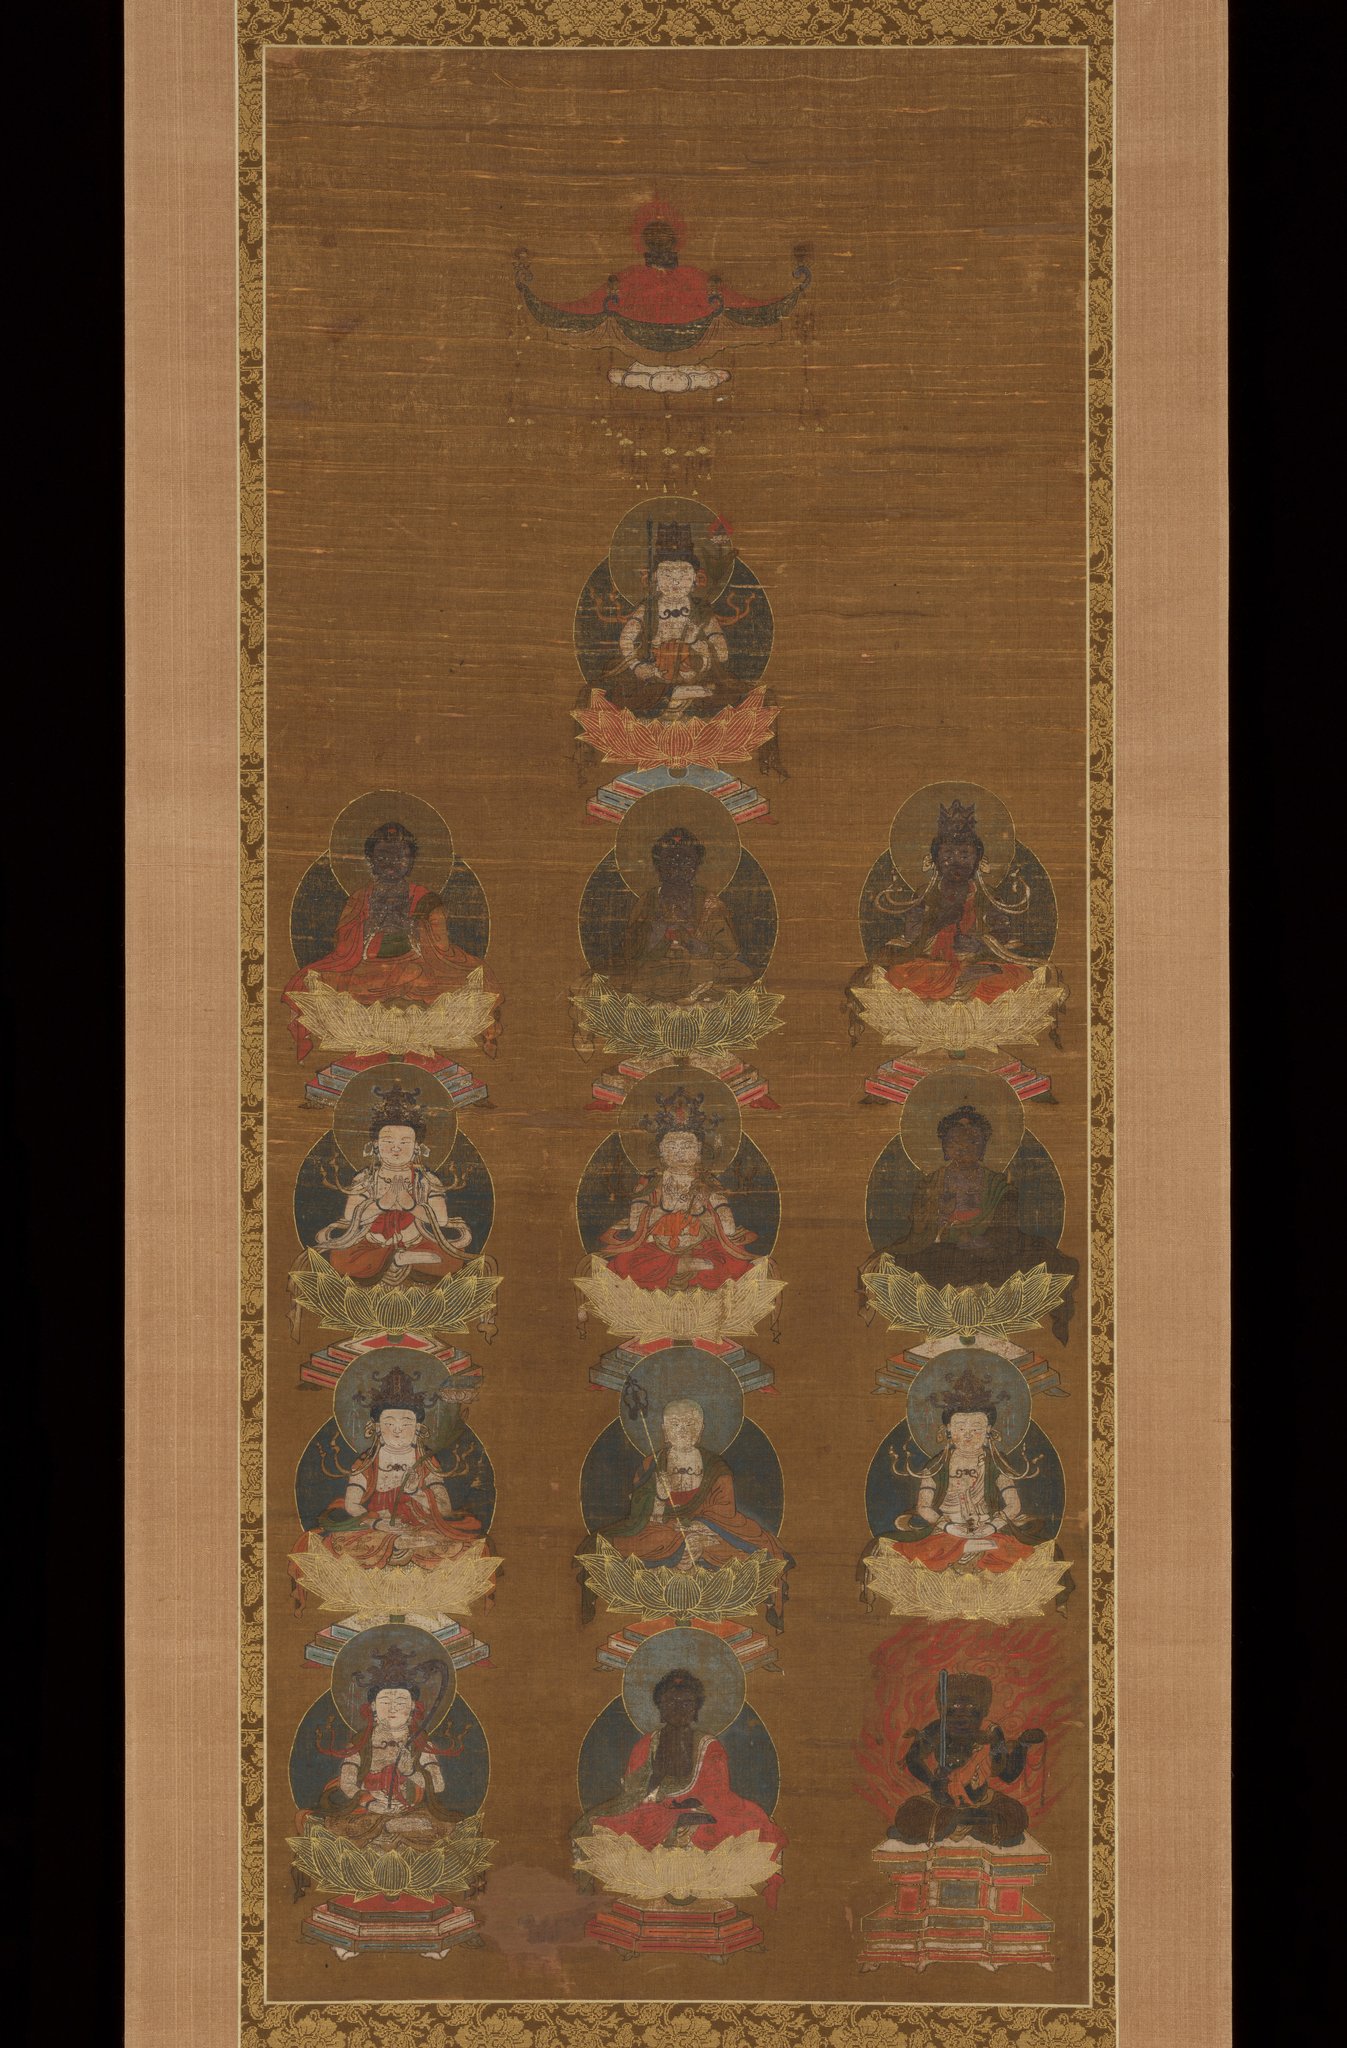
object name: hanging scroll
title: Mandala of the Thirteen Buddhas (Jūsan butsu mandara)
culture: japanese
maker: unidentified artist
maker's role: artist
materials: gold, ink, silk